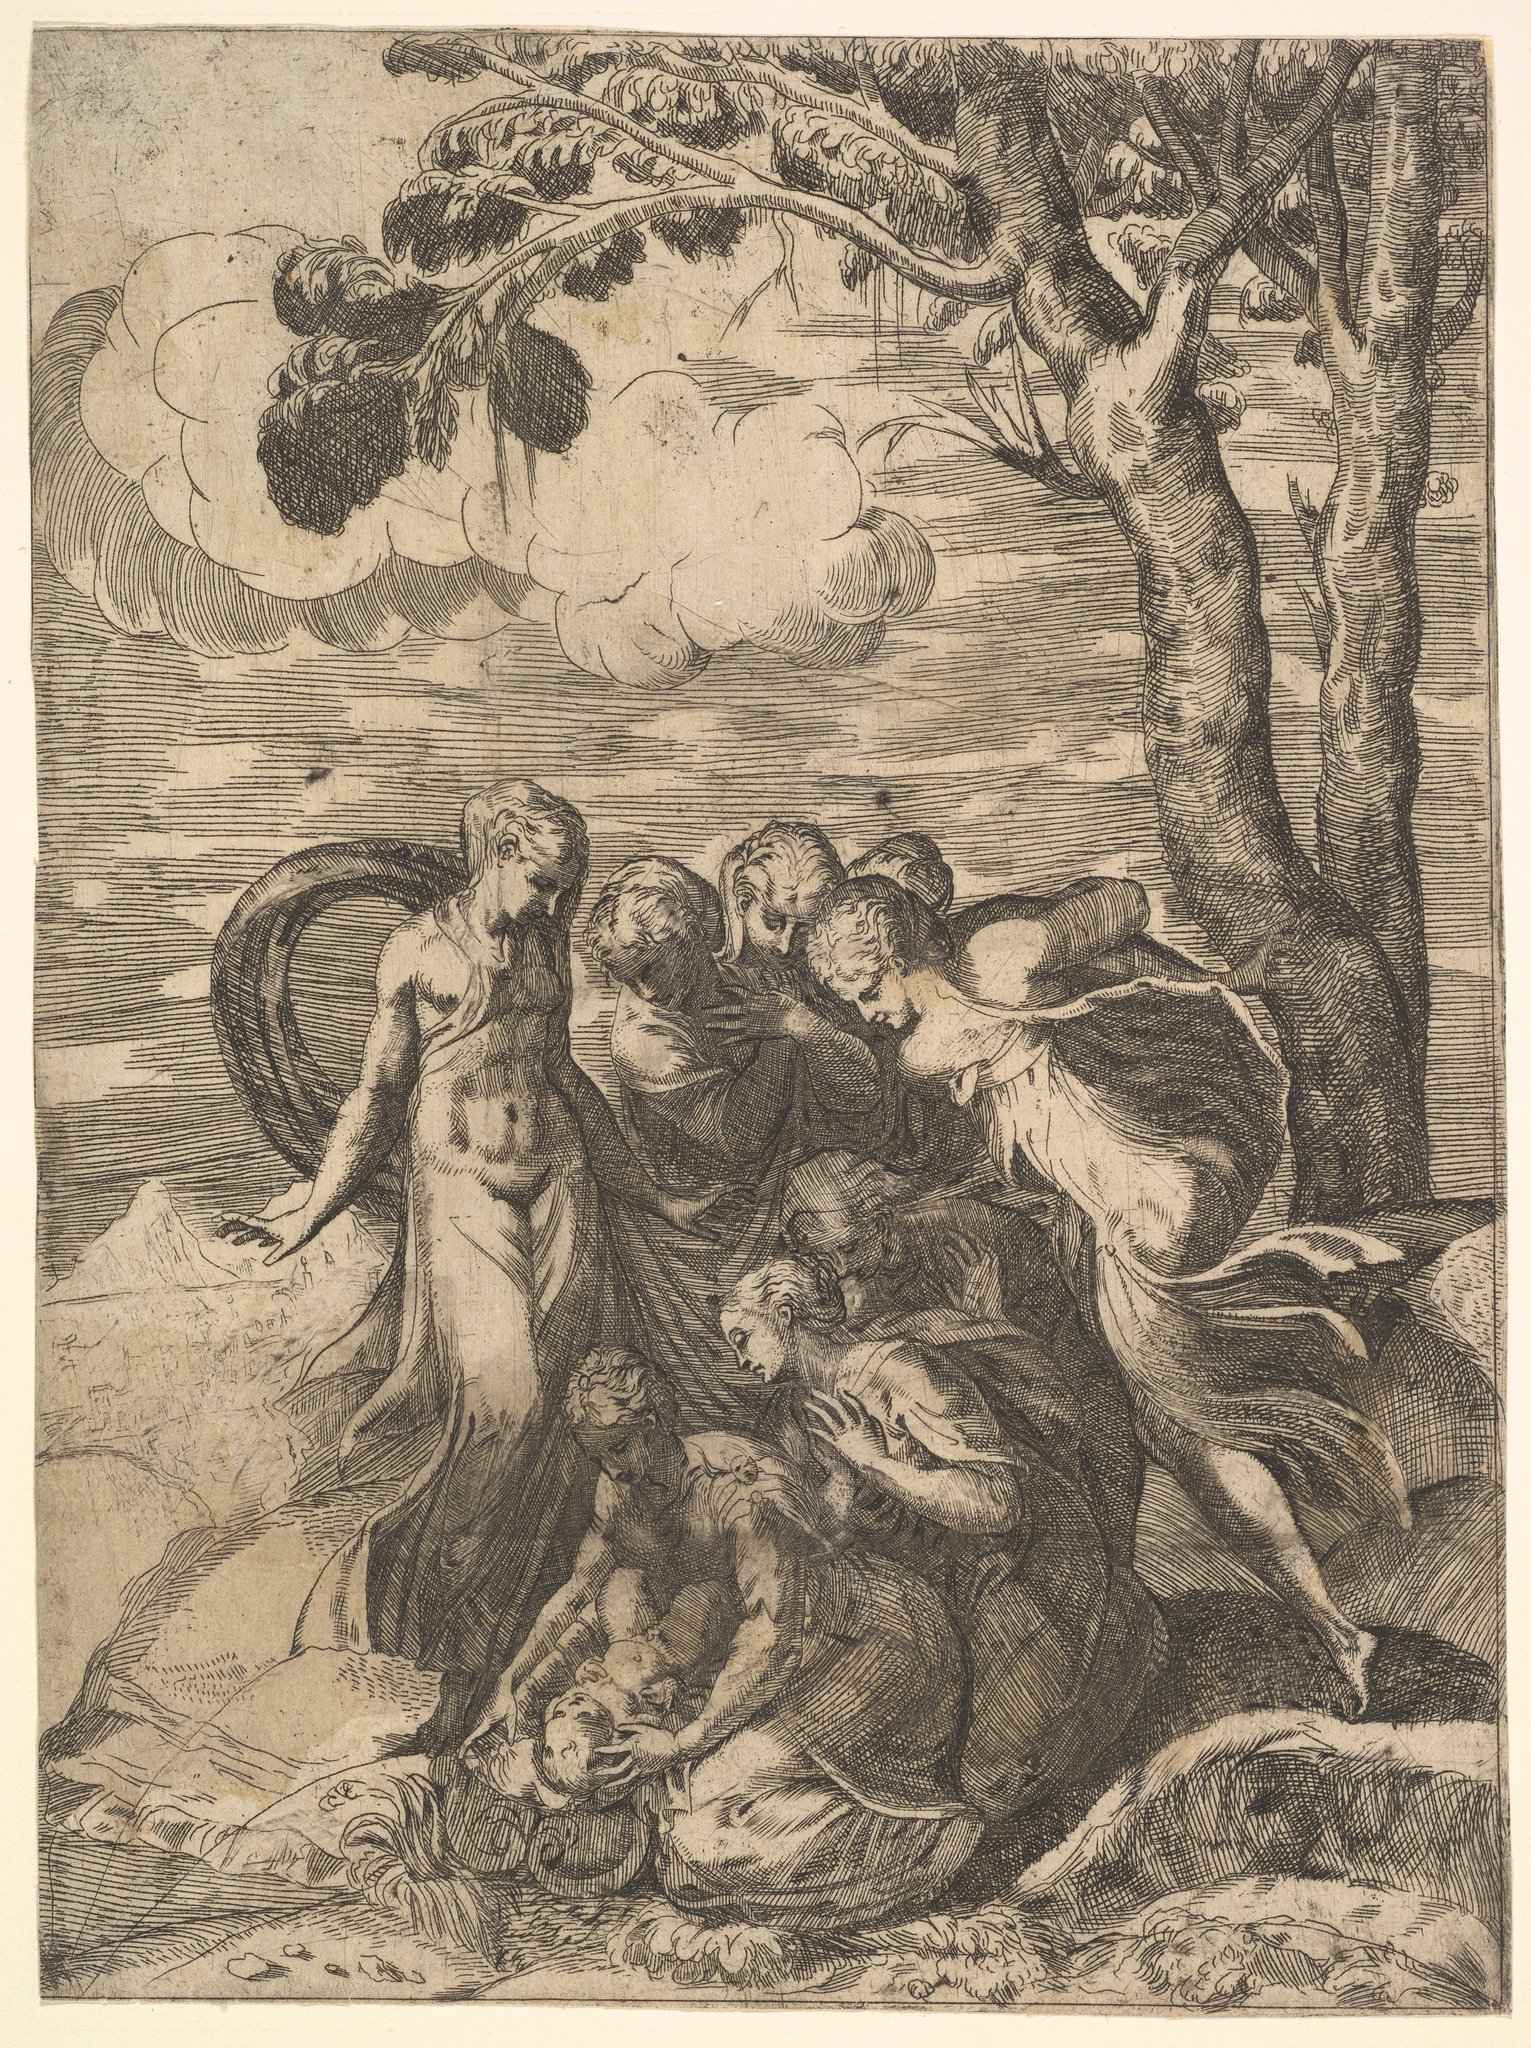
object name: print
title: Moses Rescued from the Nile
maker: battista angolo del moro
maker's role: artist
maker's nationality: italian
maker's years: 1515-1573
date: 1501-1600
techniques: etching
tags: female nudes,rivers,moses